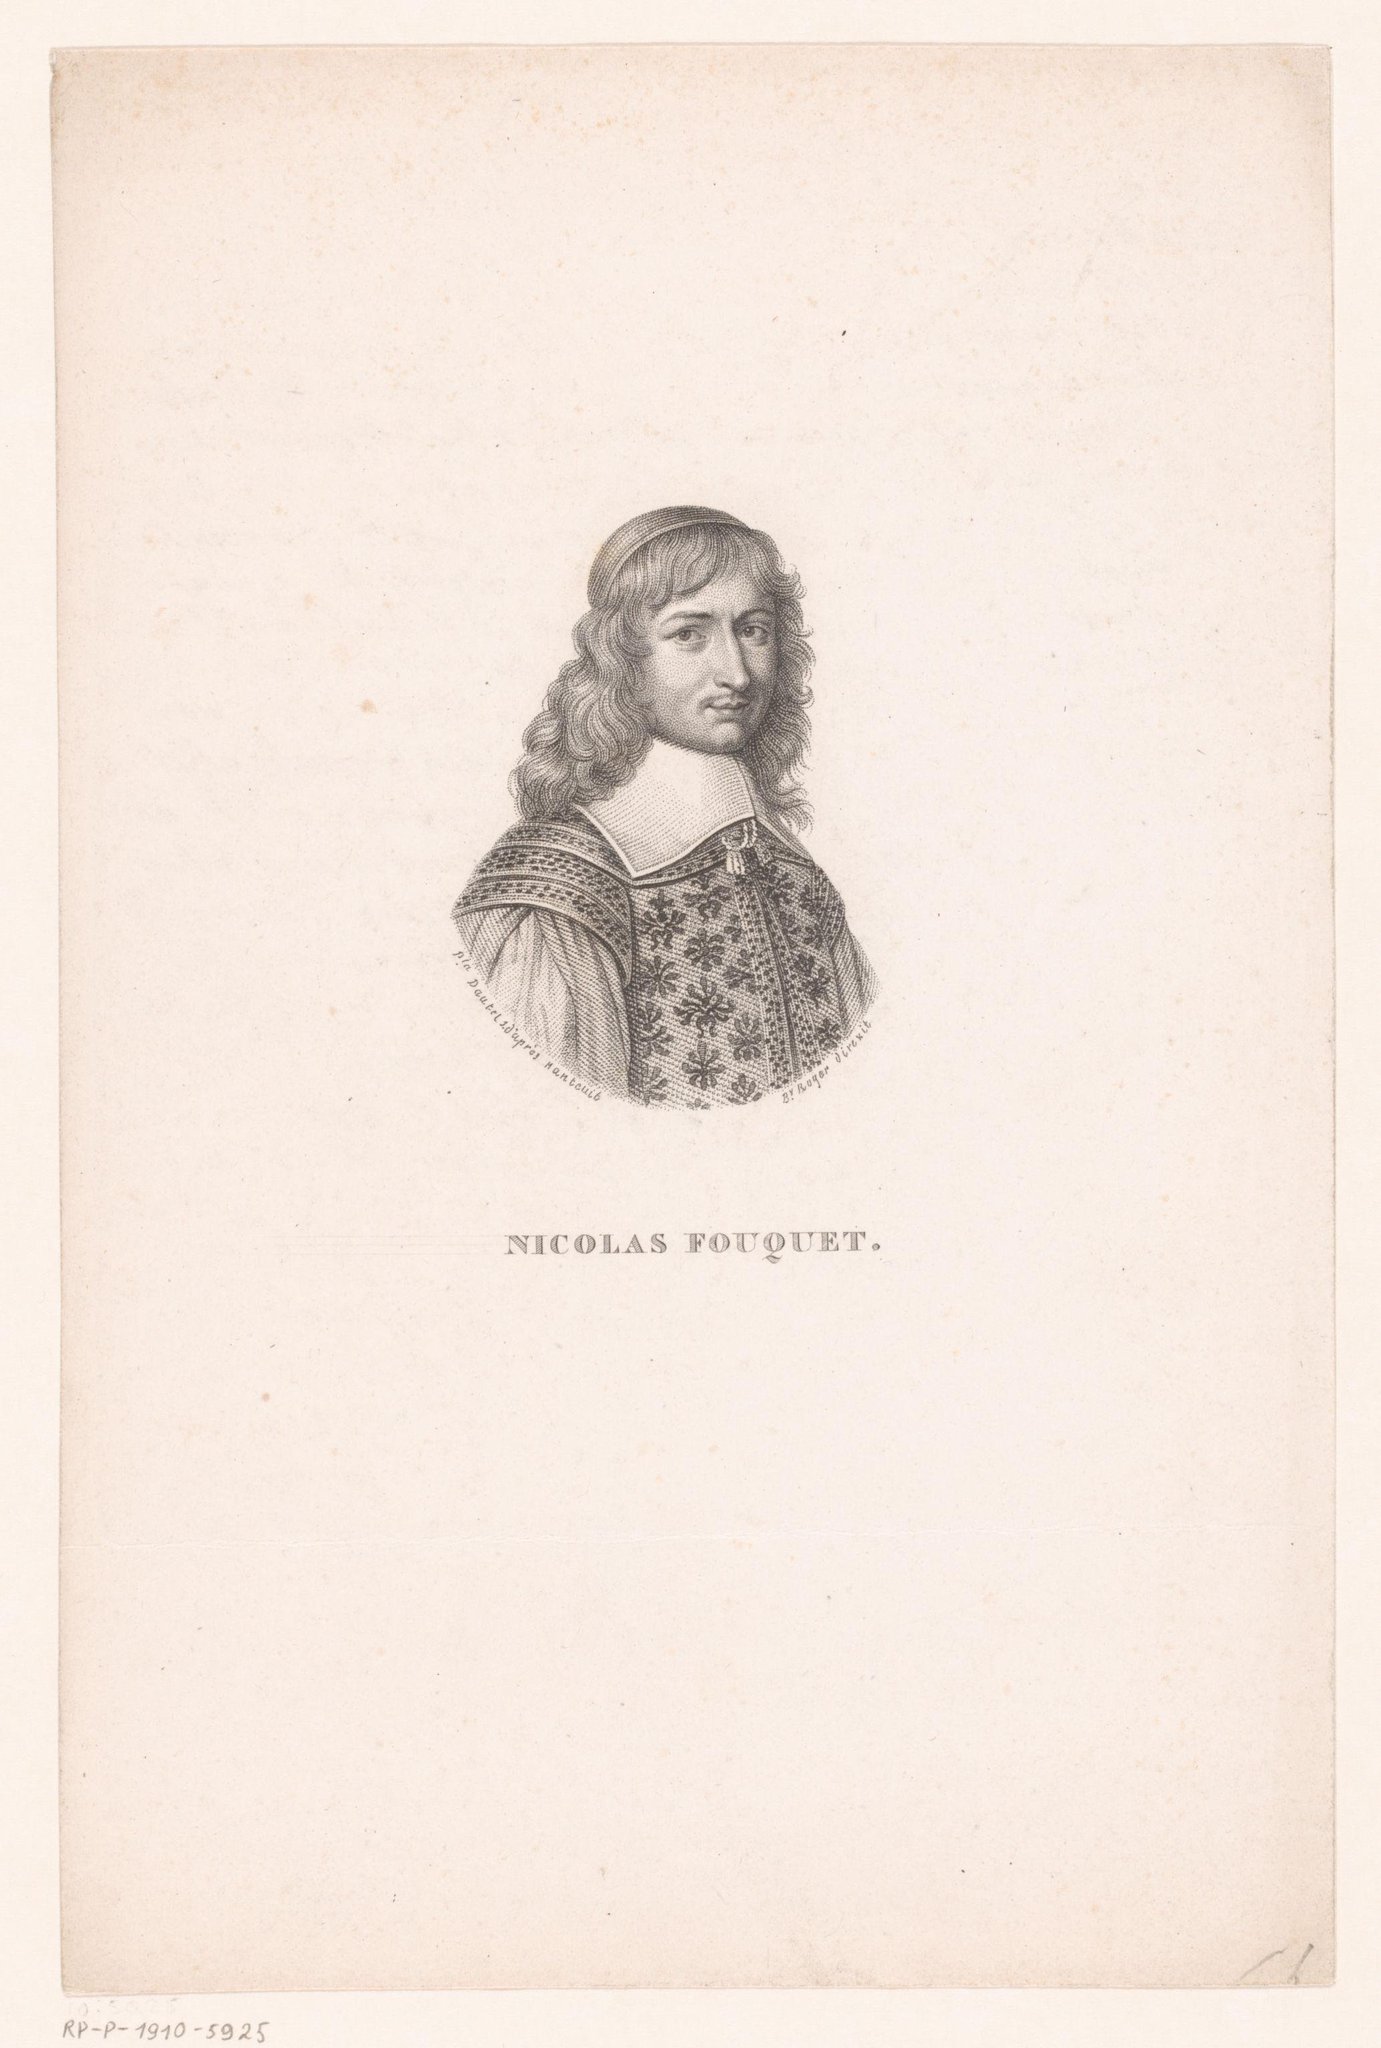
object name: print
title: Portret van Nicolas Fouquet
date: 1825-1845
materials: paper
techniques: stippling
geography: france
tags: paris, france, politician, nicolas fouquet, historical persons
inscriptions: collector's mark: Lugt 2228